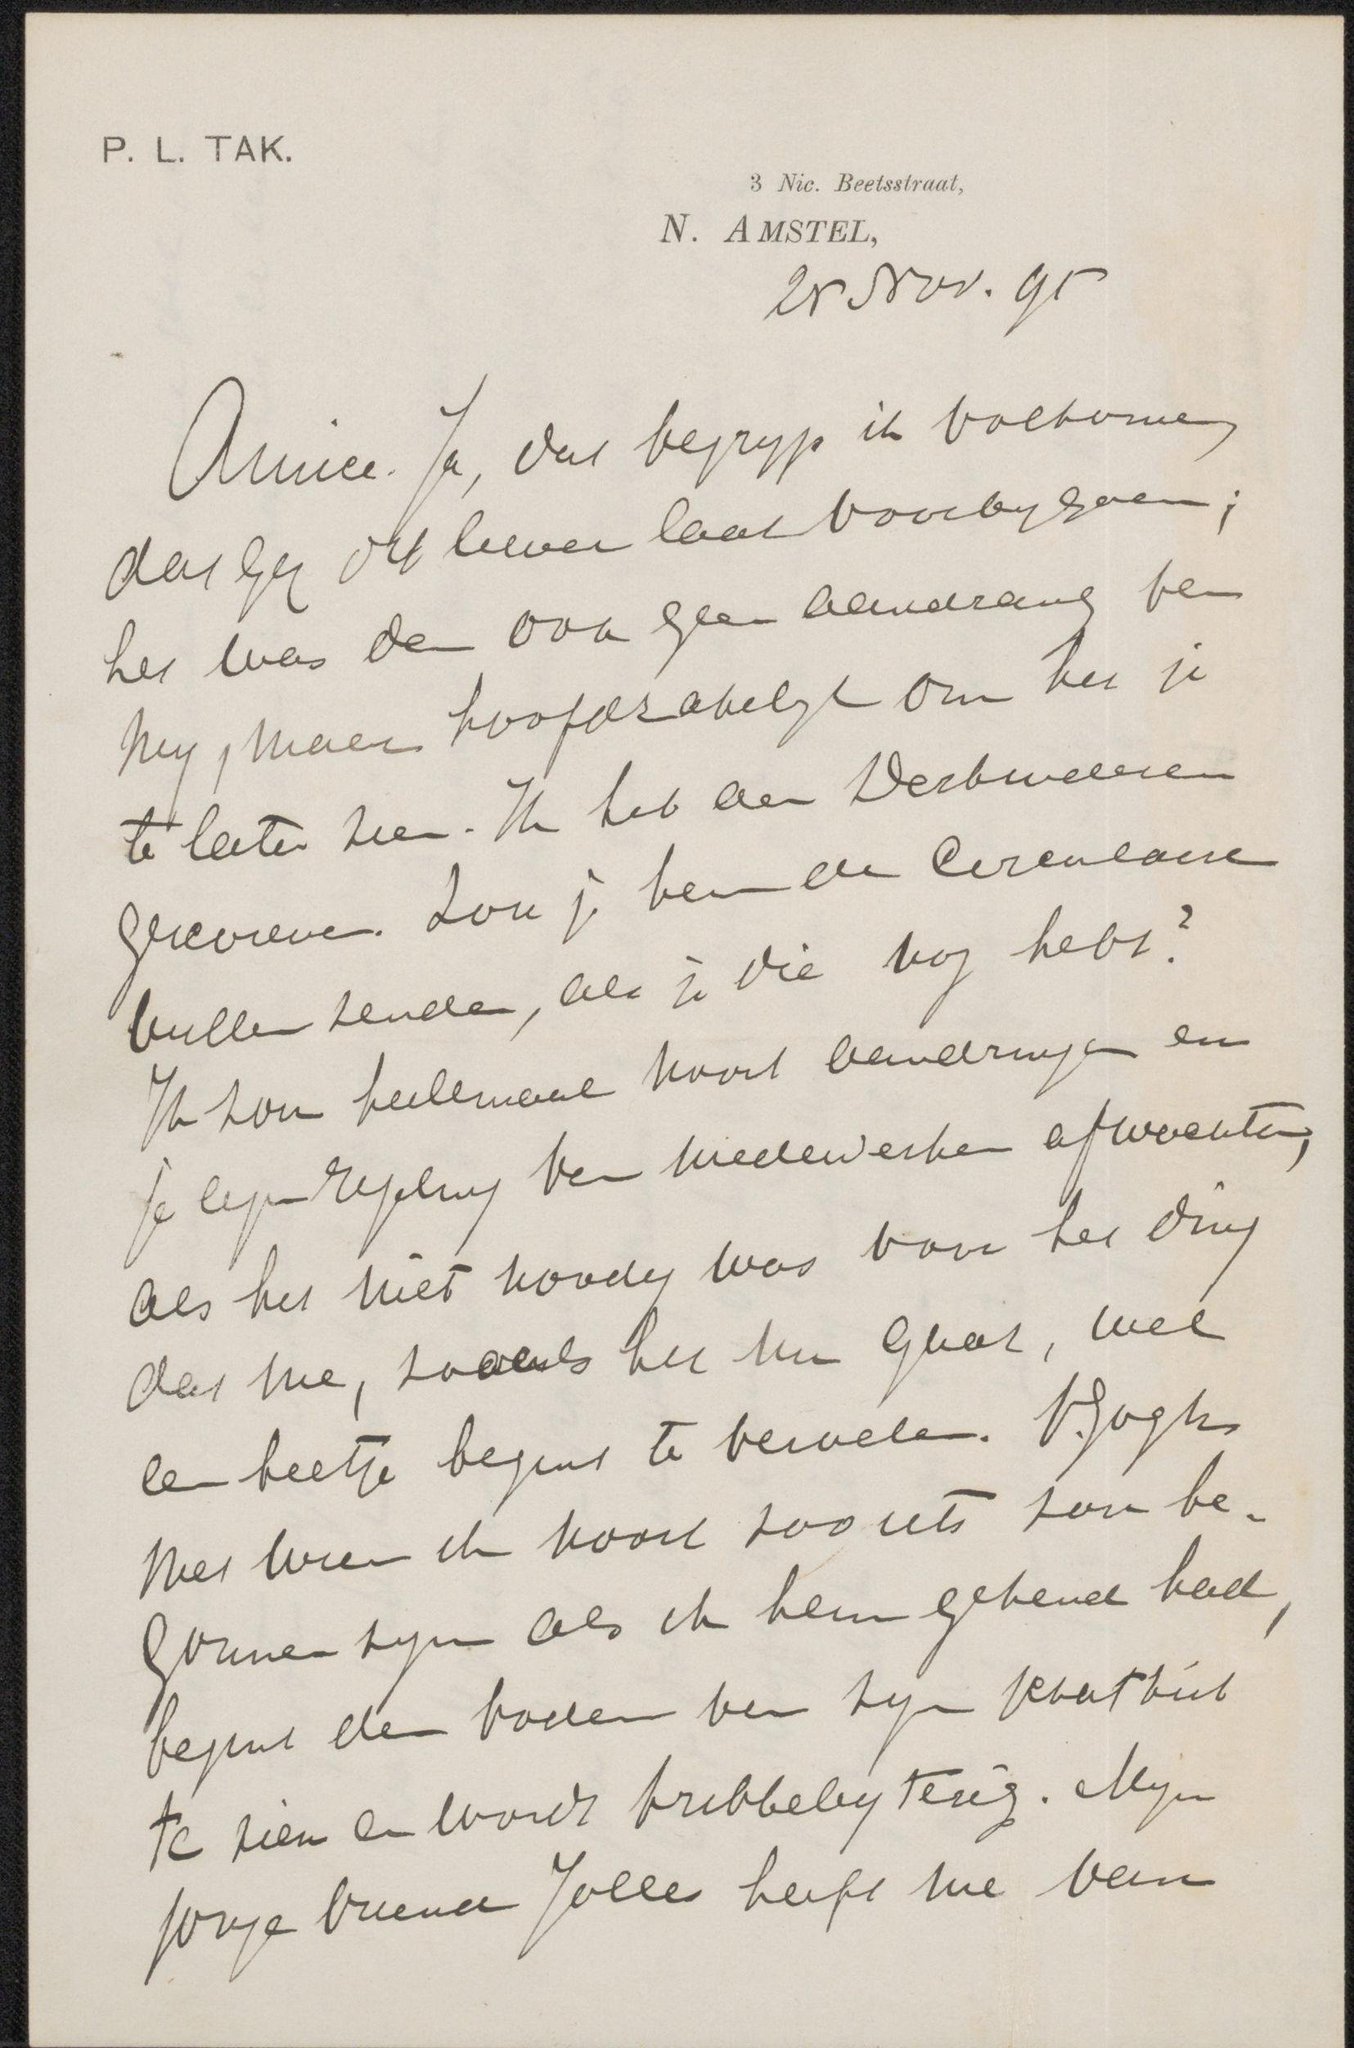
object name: letter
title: Brief aan Jan Veth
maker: pieter lodewijk tak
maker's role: politician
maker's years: 1848-1907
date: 1895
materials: ink, paper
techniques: pen, printing, writing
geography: nieuwer-amstel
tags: august allebé, dordrecht, jan veth, den bosch, amsterdam, painter, print maker, draughtsman, antoon derkinderen, eduard karsen, marius bauer, hendrik petrus berlage, lodewijk van deyssel, frank van der goes, albert verwey, jan kalff, andré jolles, printed matter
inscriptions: watermark, collector's mark: ‘RPK’